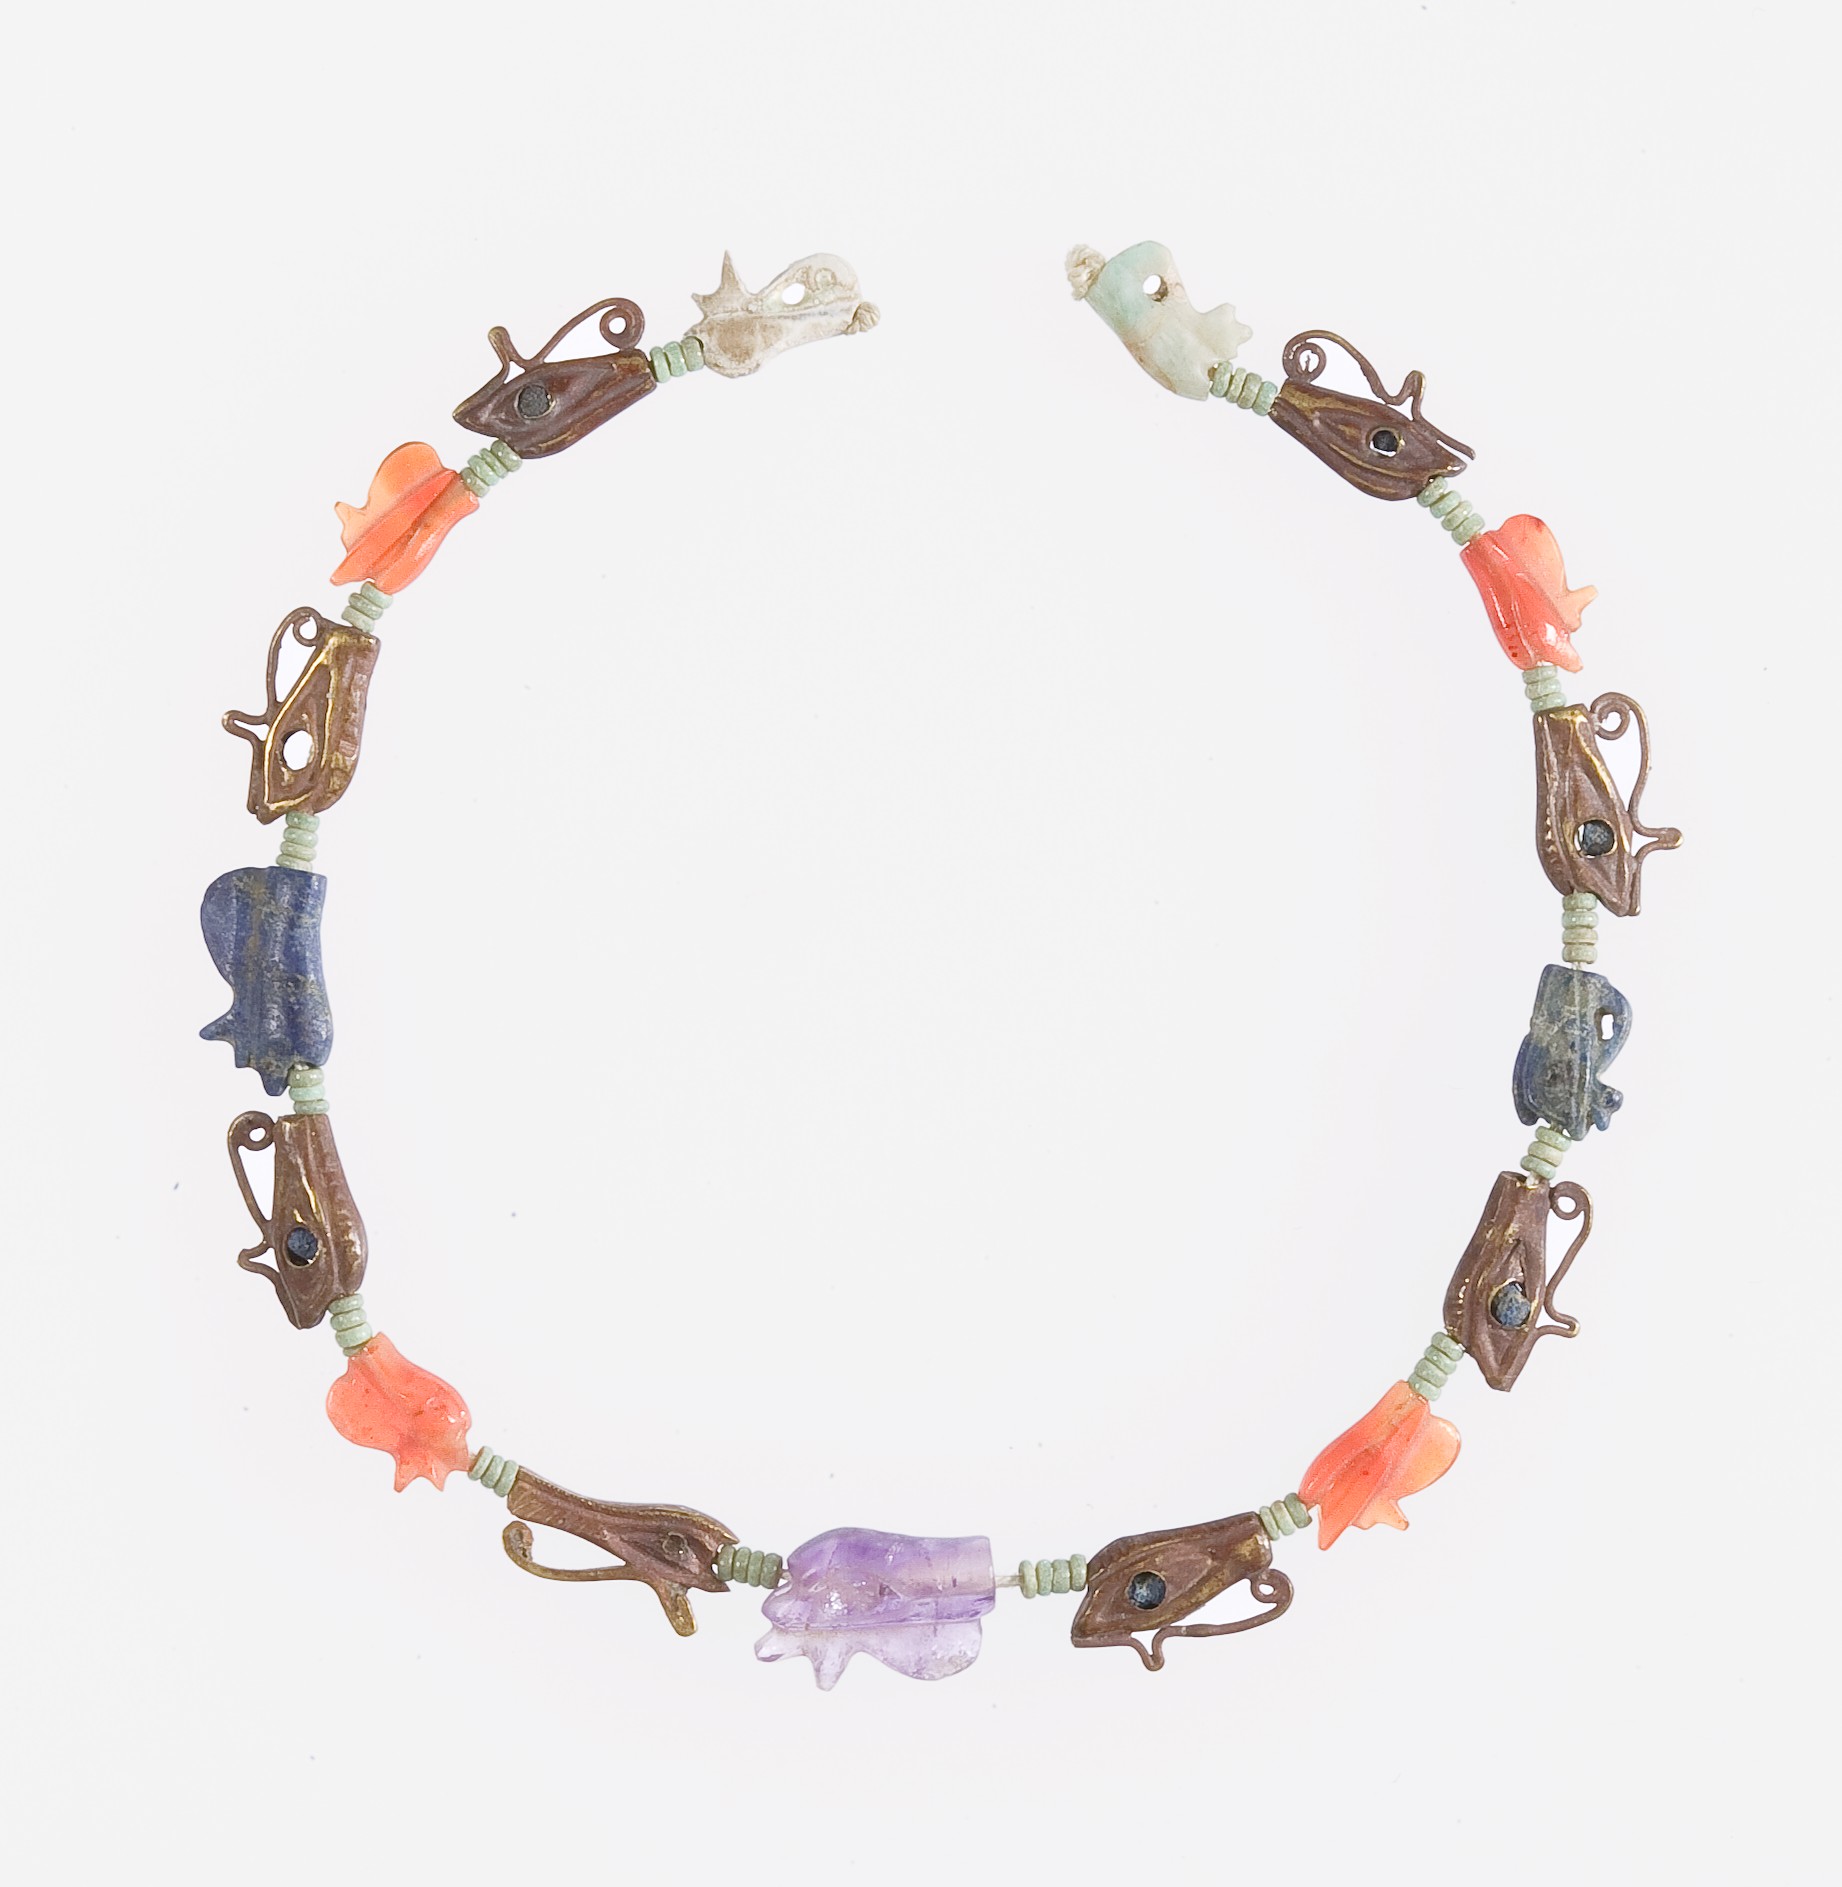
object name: amulet, wedjat eye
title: String of Wedjat Amulets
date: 1981-1640 BCE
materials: gemstone, gold, lapis lazuli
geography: egypt